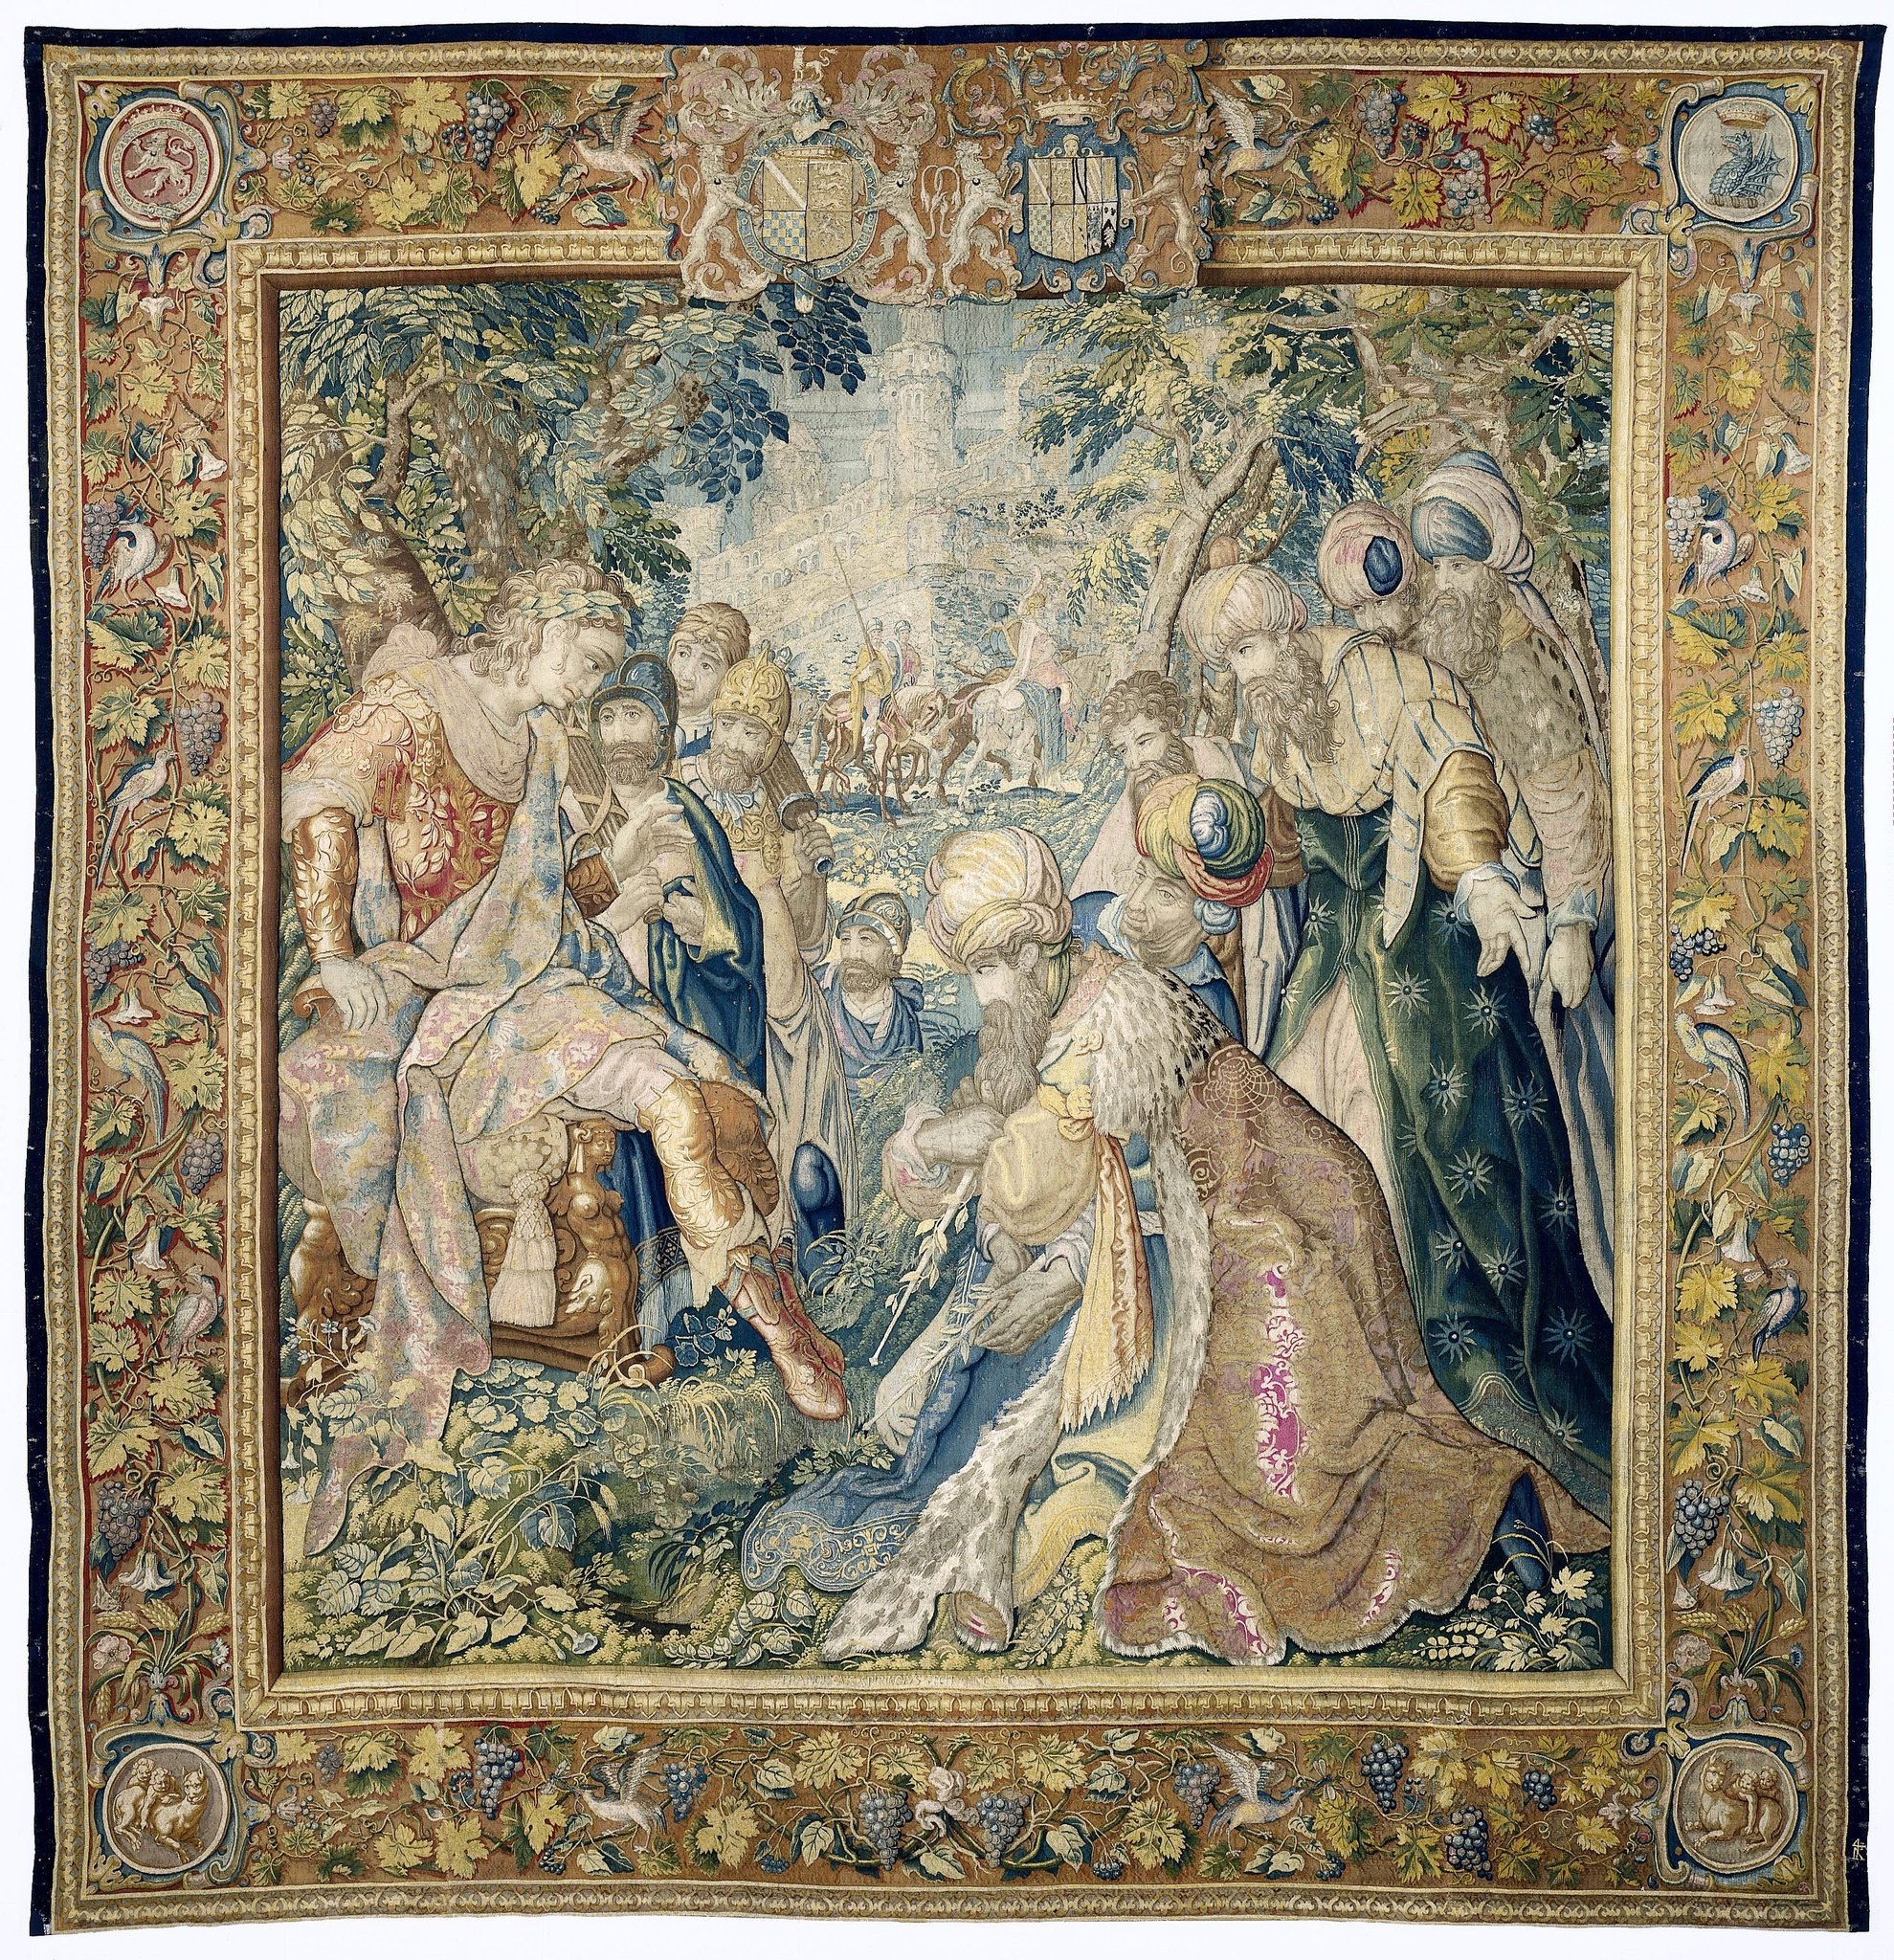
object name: tapestry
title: Scipio en de gezanten van Carthago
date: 1609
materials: silk, wool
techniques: tapestry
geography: delft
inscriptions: signature and date: ‘FRANCISCVS.PRIRINGIVS.FECIT ANNO 1609’, mark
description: Wandtapijt met de overgave van Carthago, 201 v. Chr. uit een Scipio-historie van acht stuks, voor Thomas Howard, 1ste graaf van Suffolk en zijn vrouw Catherine Knyvet. Signatuur "FRANCISCUS. SPIRINGIVS. FECIT. ANNO 1609.